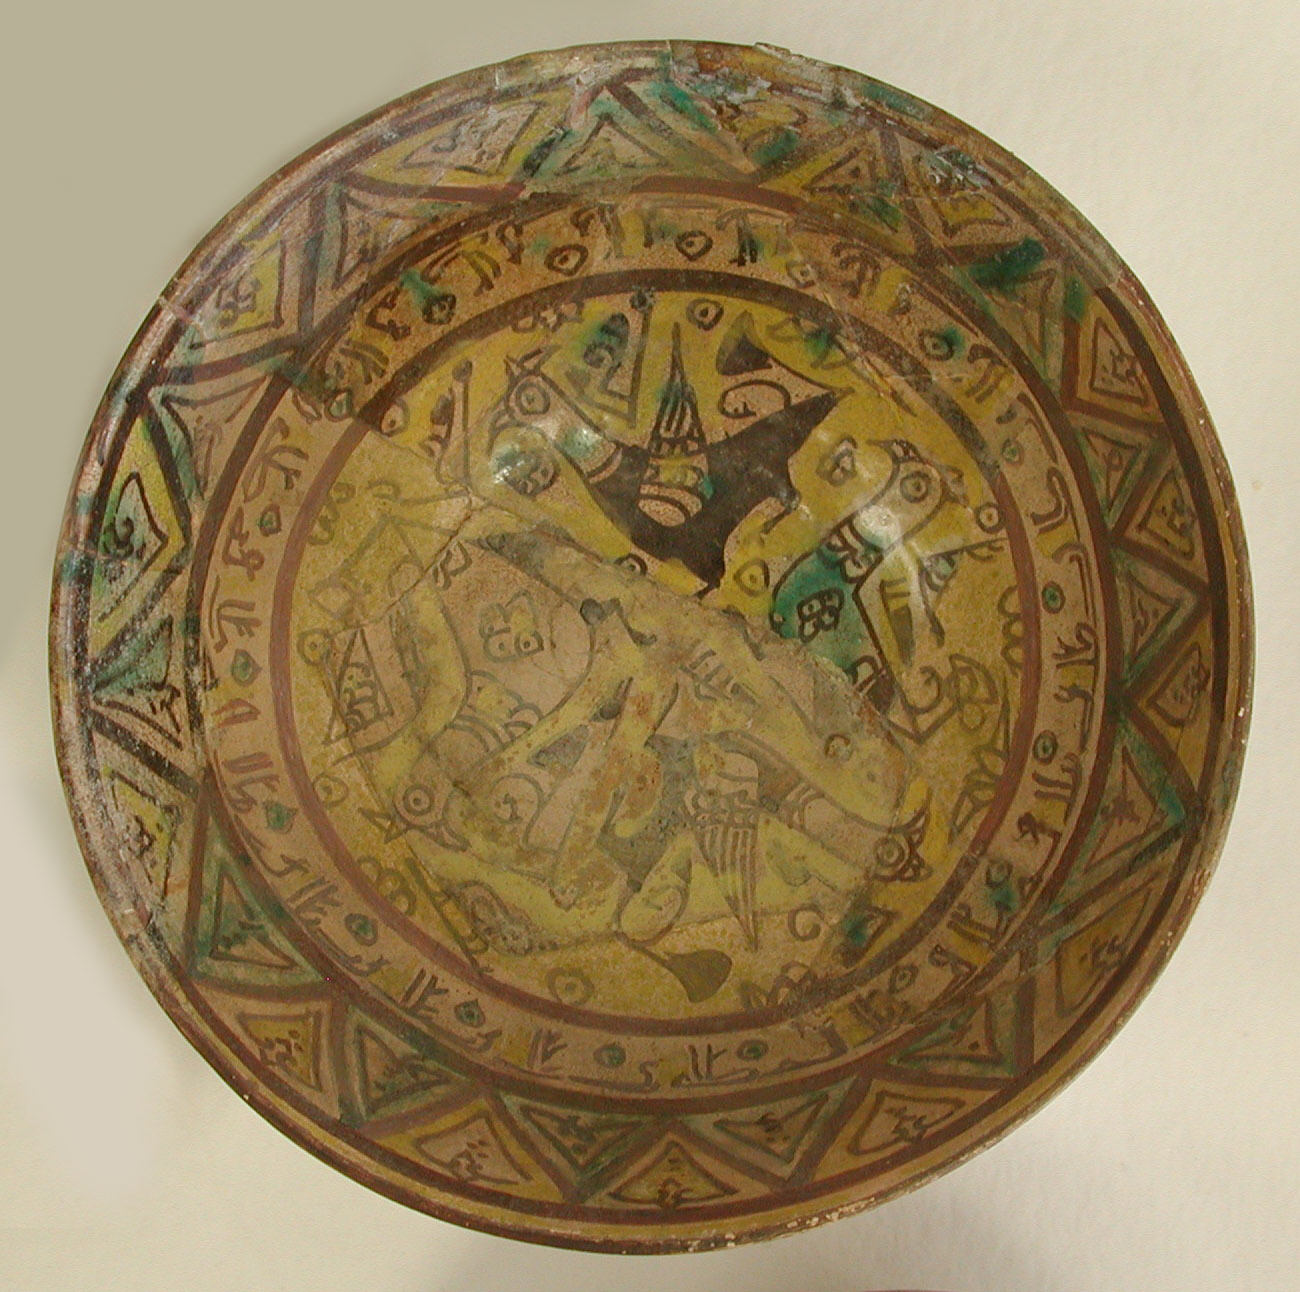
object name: bowl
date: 801-900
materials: earthenware, glaze, pigment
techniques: painting, polychrome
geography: iran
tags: birds